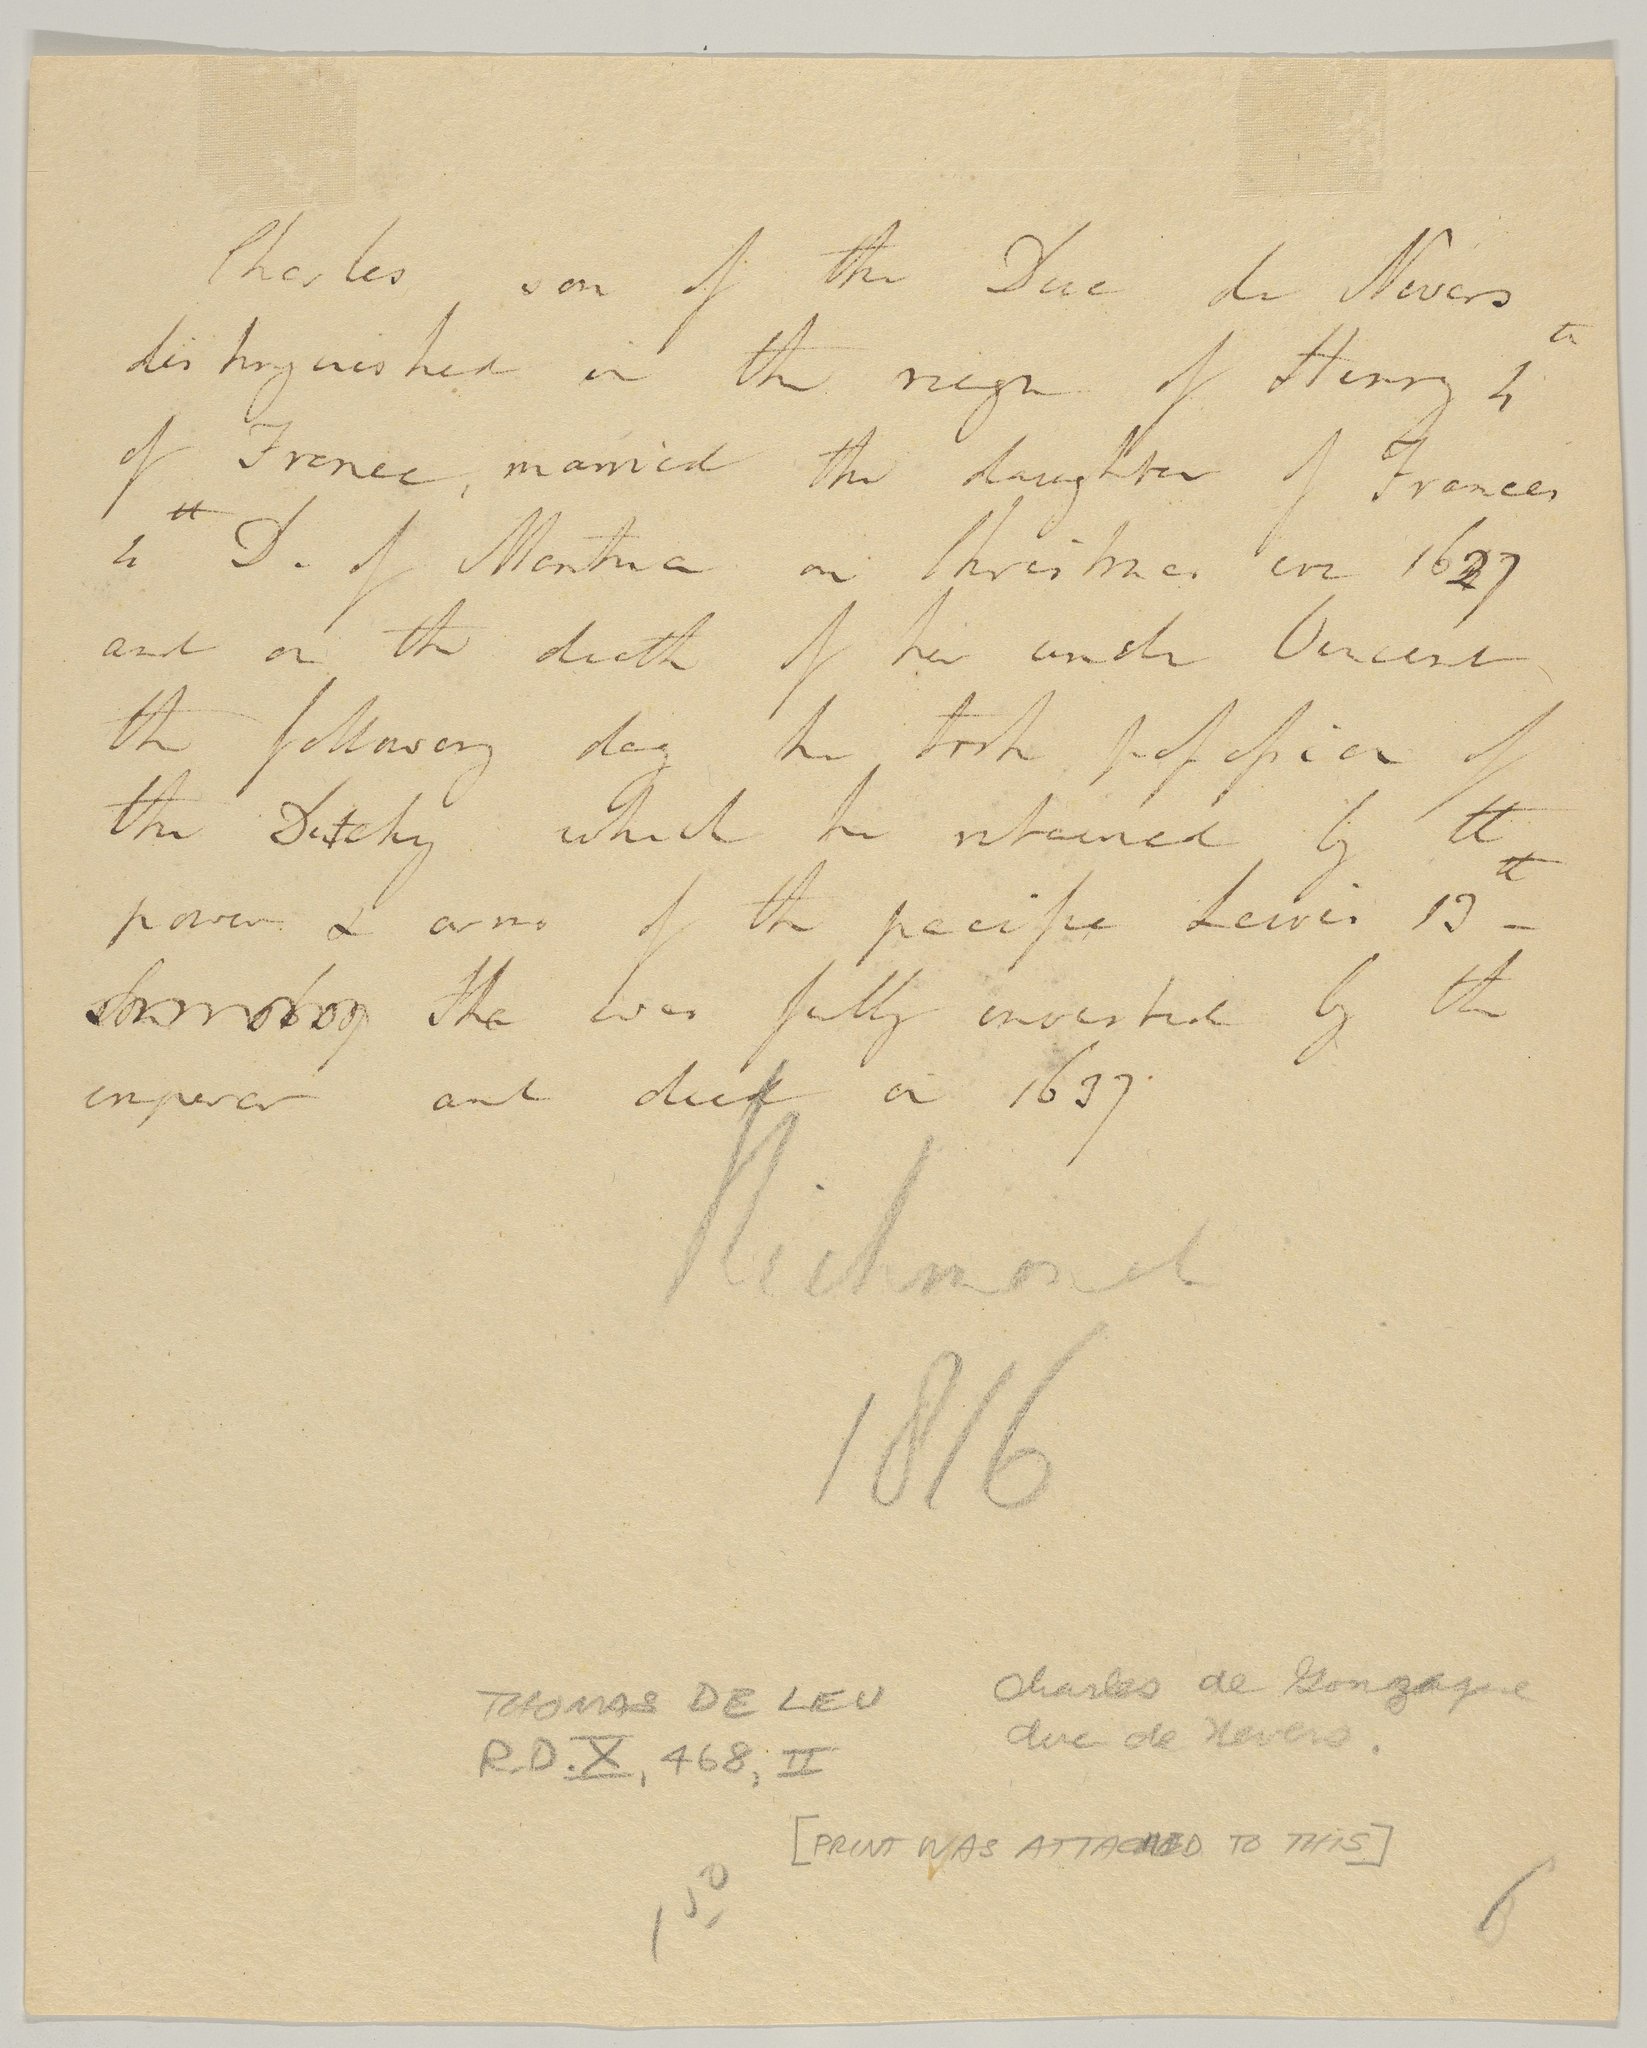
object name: print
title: Charles de Gonzague, Duc de Nevers, attached letter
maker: thomas de leu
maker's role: artist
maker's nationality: french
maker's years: 1560-1620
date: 1501-1700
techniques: etching